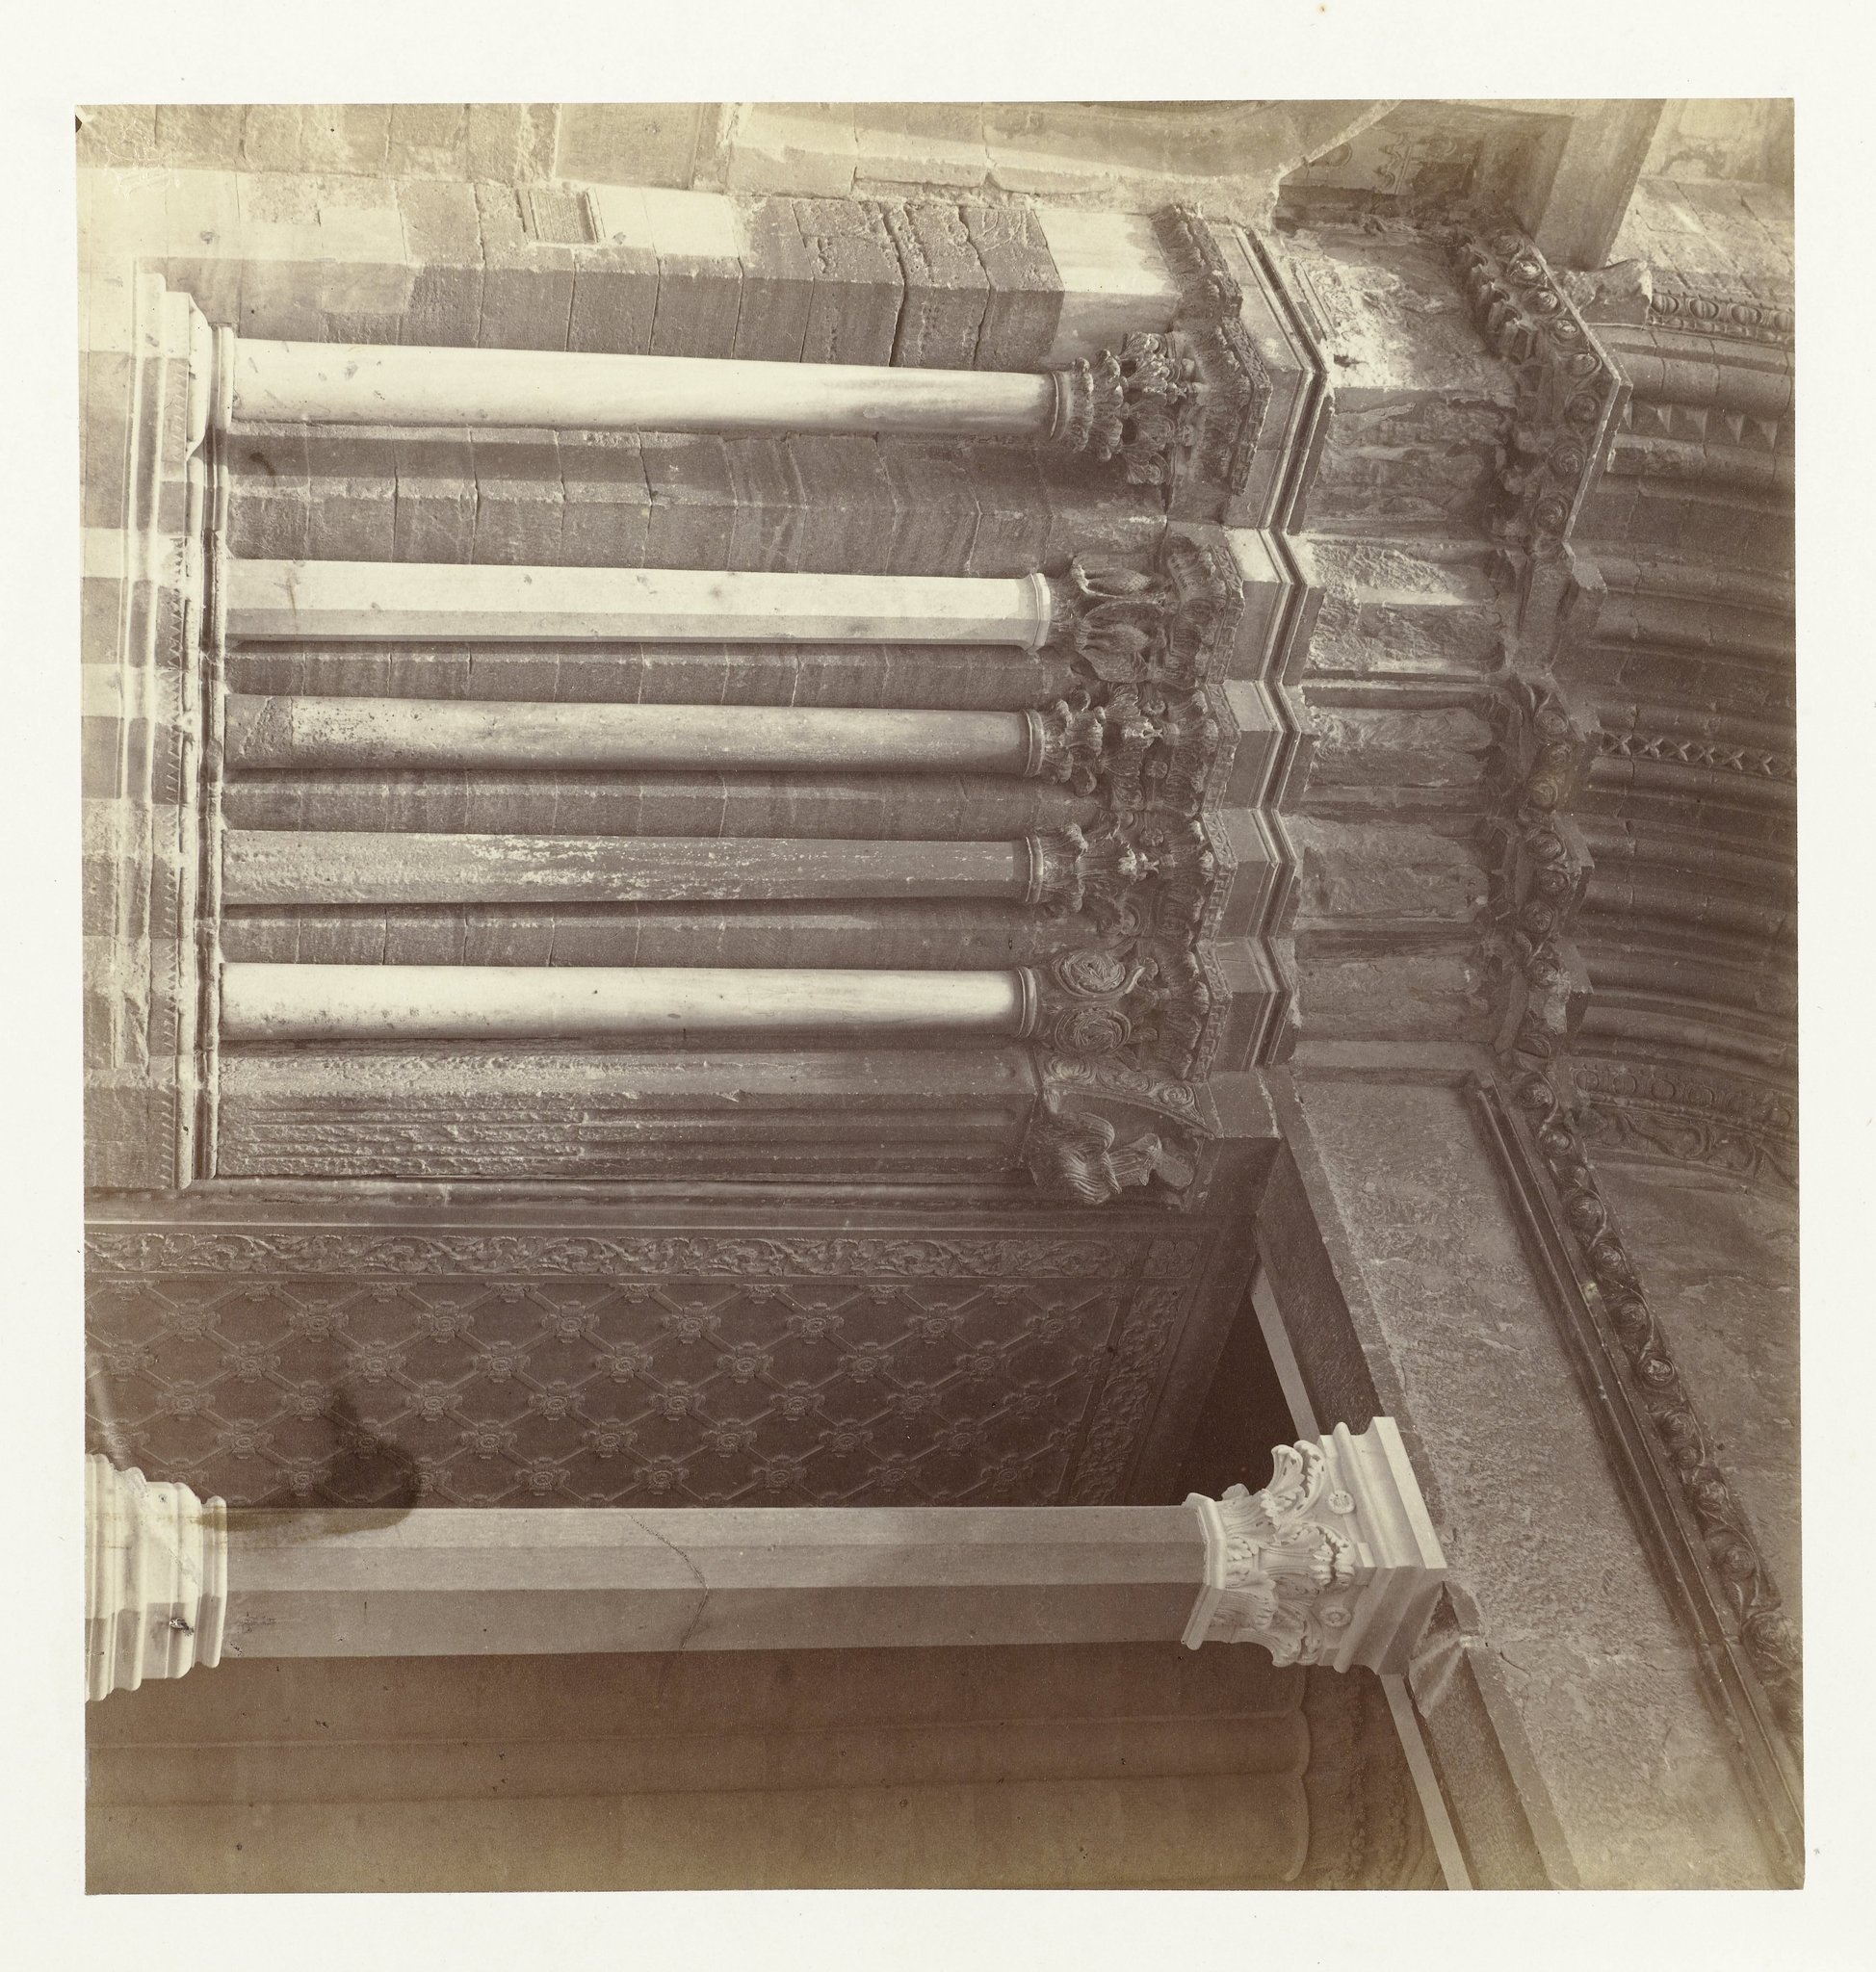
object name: photograph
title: Zuilen van het zuidelijk portaal van de Église Sainte-Marthe de Tarascon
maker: Anonymous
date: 1858-1861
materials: cardboard, paper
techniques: albumen print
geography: tarascon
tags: parts of church exterior and annexes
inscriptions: monogram: ‘APA’, address: ‘168 NEW BOND ST.’, number: ‘21’